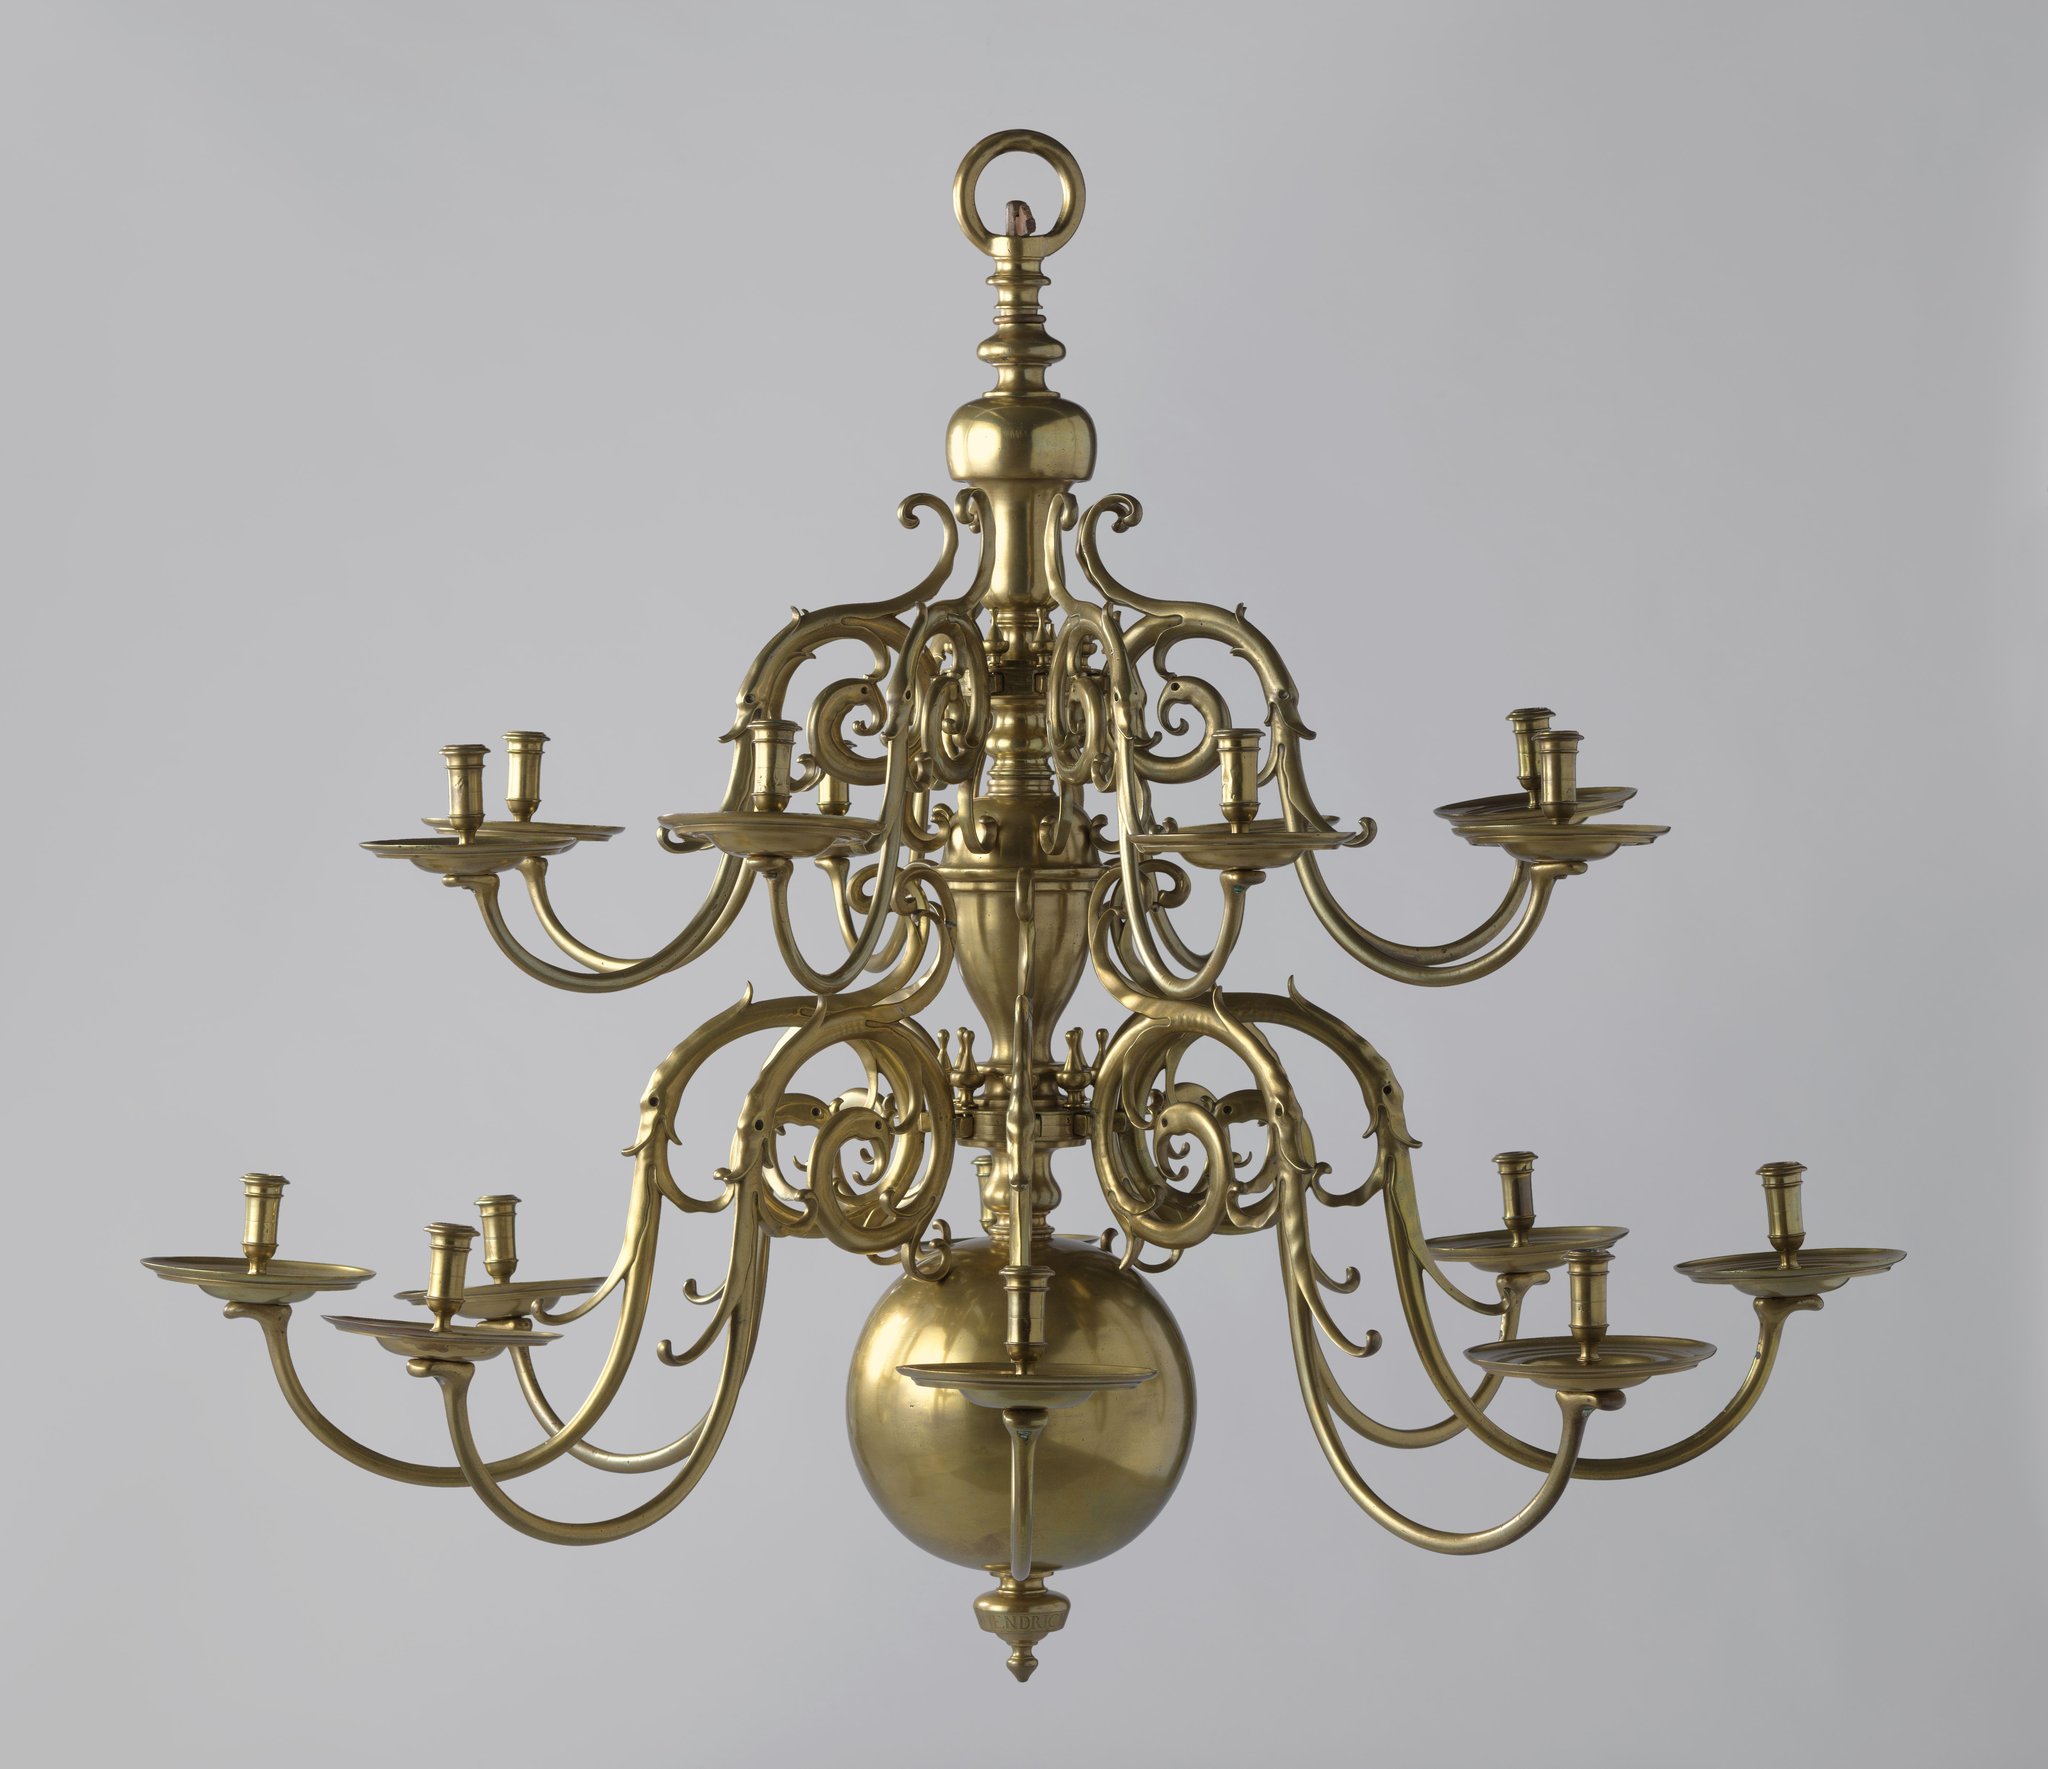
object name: chandelier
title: Arm met kaarsenhouder van kaarsenkroon van twee hoogten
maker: Anonymous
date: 1650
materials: brass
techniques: casting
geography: amsterdam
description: Kaarsenarm behorende bij een messing kaarsenkroon van twee hoogten. De S-vormige arm heeft een krul bij de aanzet, halverwege een dolfijnenkop en gaat naar buiten toe over in het platte verdikking met een schroefgat. Daarin is de kaarsenhouder met de vetvanger vastgezet. De vetvanger is aan de onderzijde geribd geprofileerd rond de opening en heeft een naar onder en een iets uitstekend randje. De cylindrische kaarsenhouder heeft een geprofileerde en een uitstekende rand, twee gegroefde ringen, een rib en een geprofileerd smaller onderstuk, dat overgaat in een uitsteeksel met een schroefdraad met een centergat. De pin om de arm te bevestigen is kegelvormig met een ronde knop bovenop. De vetvanger heeft een dichtgemaakt, rond gat, dat er op wijst dat de kaarsenkroon ooit geëlectrifieerd is geweest. Dit is de eerste arm van de bovenste standring, genummerd met het cijfer 8.